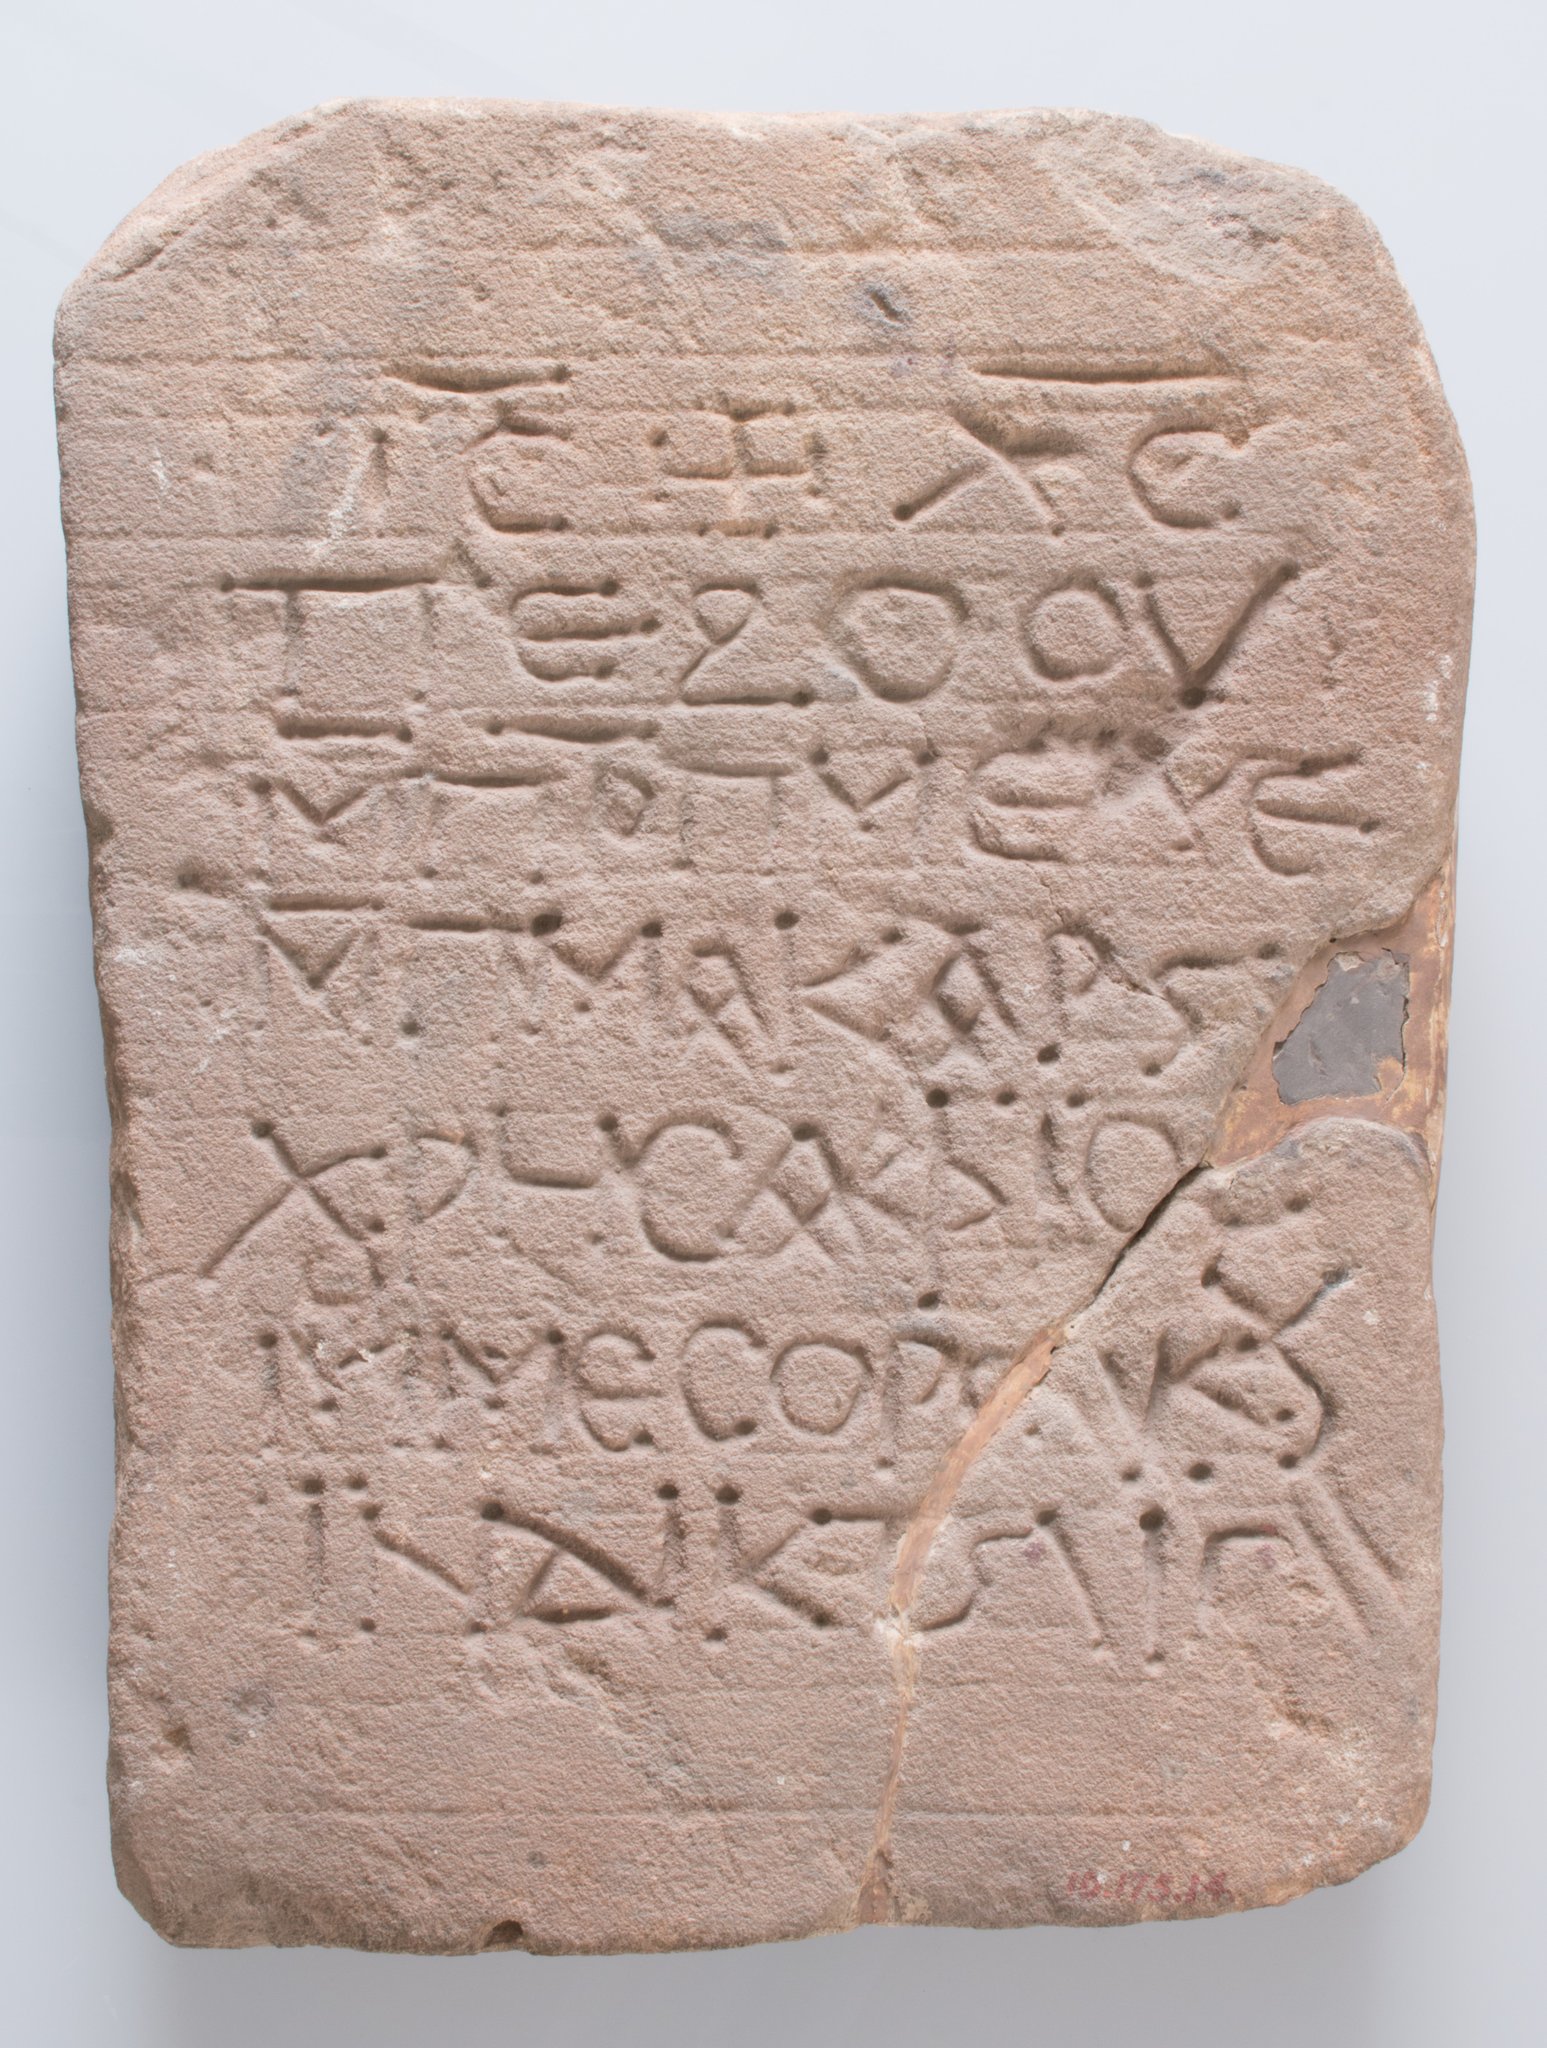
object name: stele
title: Stele of "Blessed Chrysaphios"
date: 201-1200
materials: stone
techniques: incising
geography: egypt